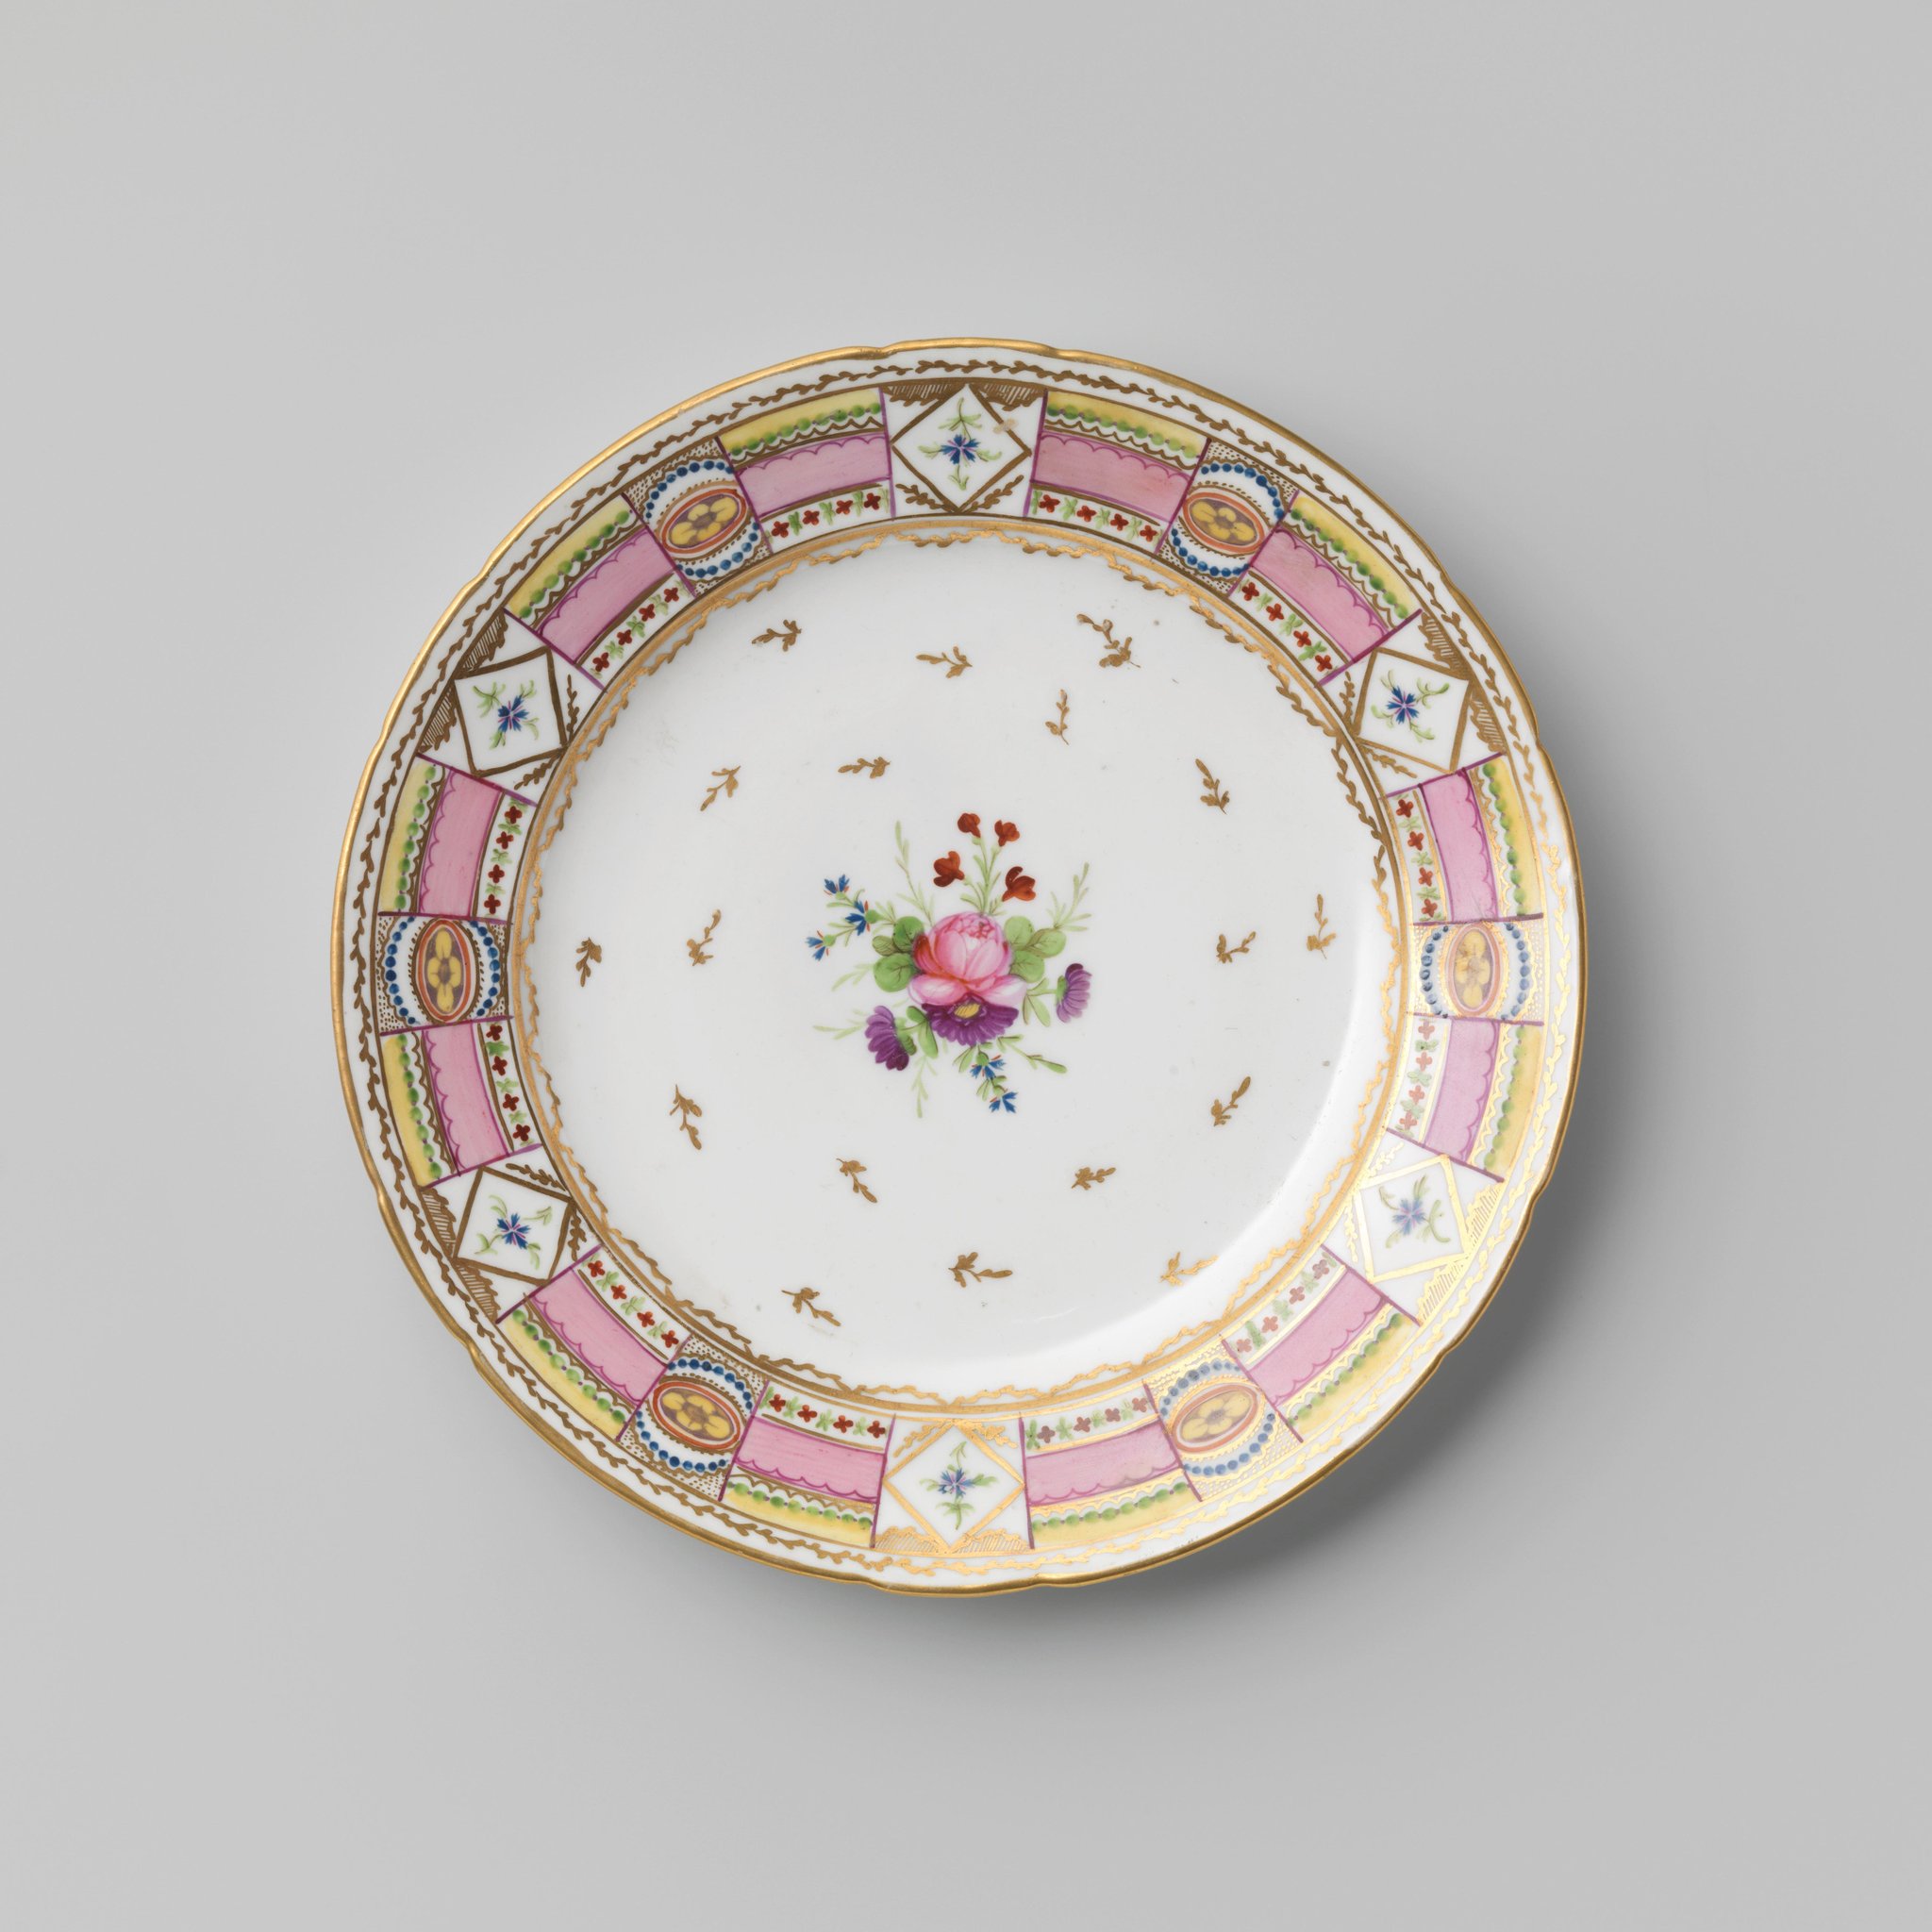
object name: plate dish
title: Plate with a bouquet, flower sprays and an ornamental border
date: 1790-1800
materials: glaze, gold, paint, porcelain, soft paste porcelain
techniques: firing, gilding, turning, vitrification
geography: bordeaux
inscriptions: mark: ‘W’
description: Bord van soft-paste porselein (pâte tendre) met een licht gelobde rand, beschilderd op het glazuur in blauw, rood, roze, groen, geel, paars en goud. Op het plat een boeket van verschillende bloemen omgeven door strooibloemen. De wand met een bladrank. De rand is verdeeld in vakken met afwisselend een bloemrank of rozet en drie decoratieve banden. Hierboven een bladrank. Gouden rand. Gemerkt op de onderzijde met een W.